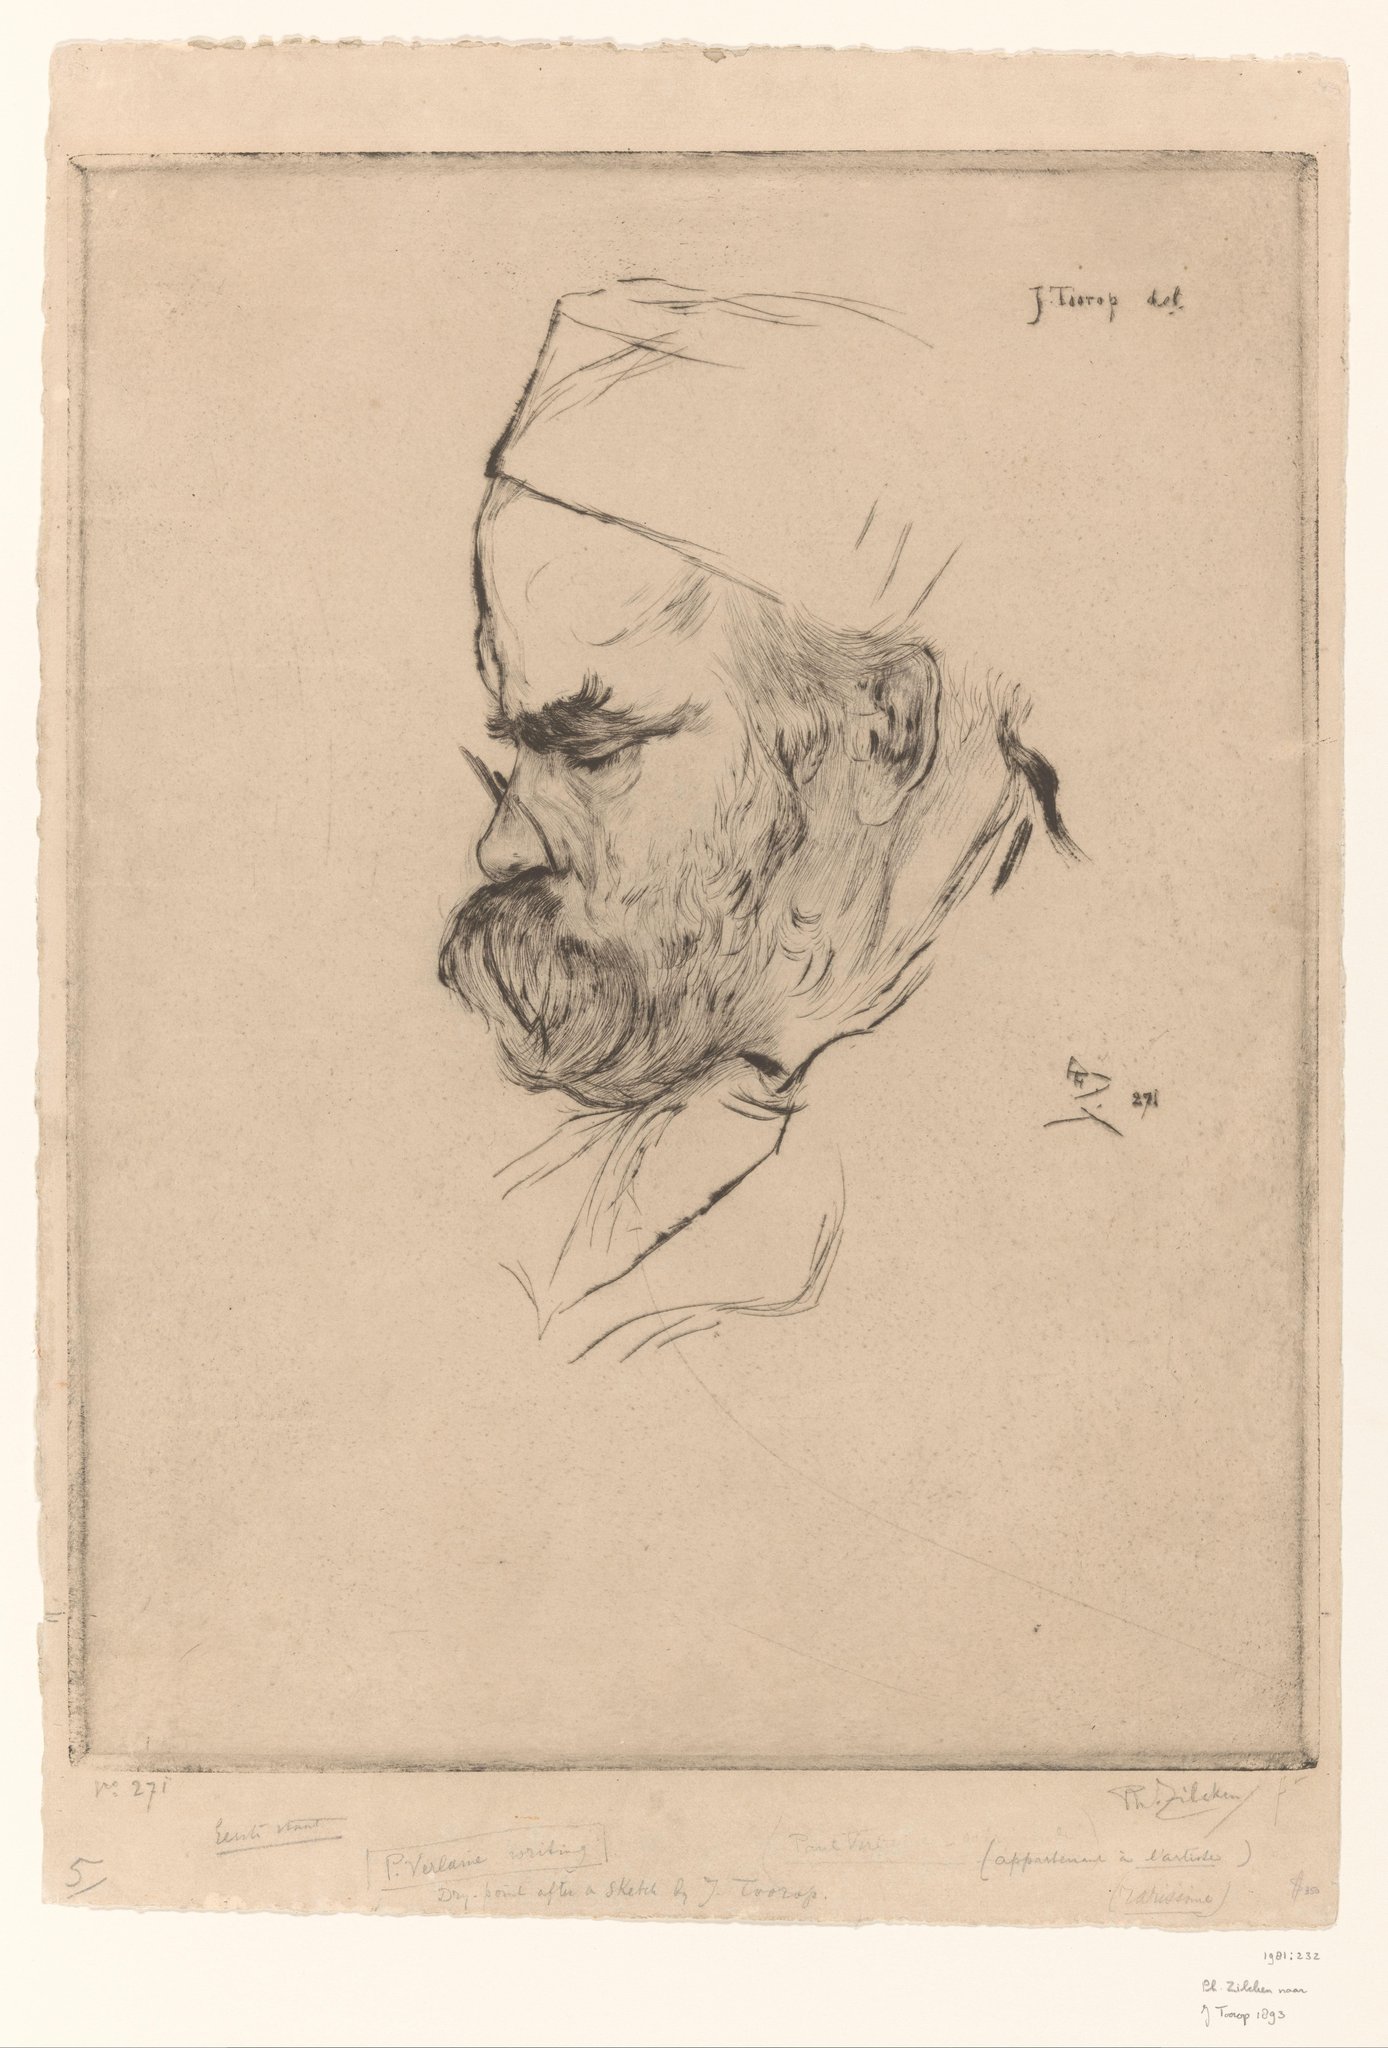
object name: print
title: Portret van Paul Verlaine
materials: paper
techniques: drypoint, intaglio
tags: paul verlaine, historical persons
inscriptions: annotation: ‘P. Verlaine. écrivant à (...)’, collector's mark: Lugt 2228